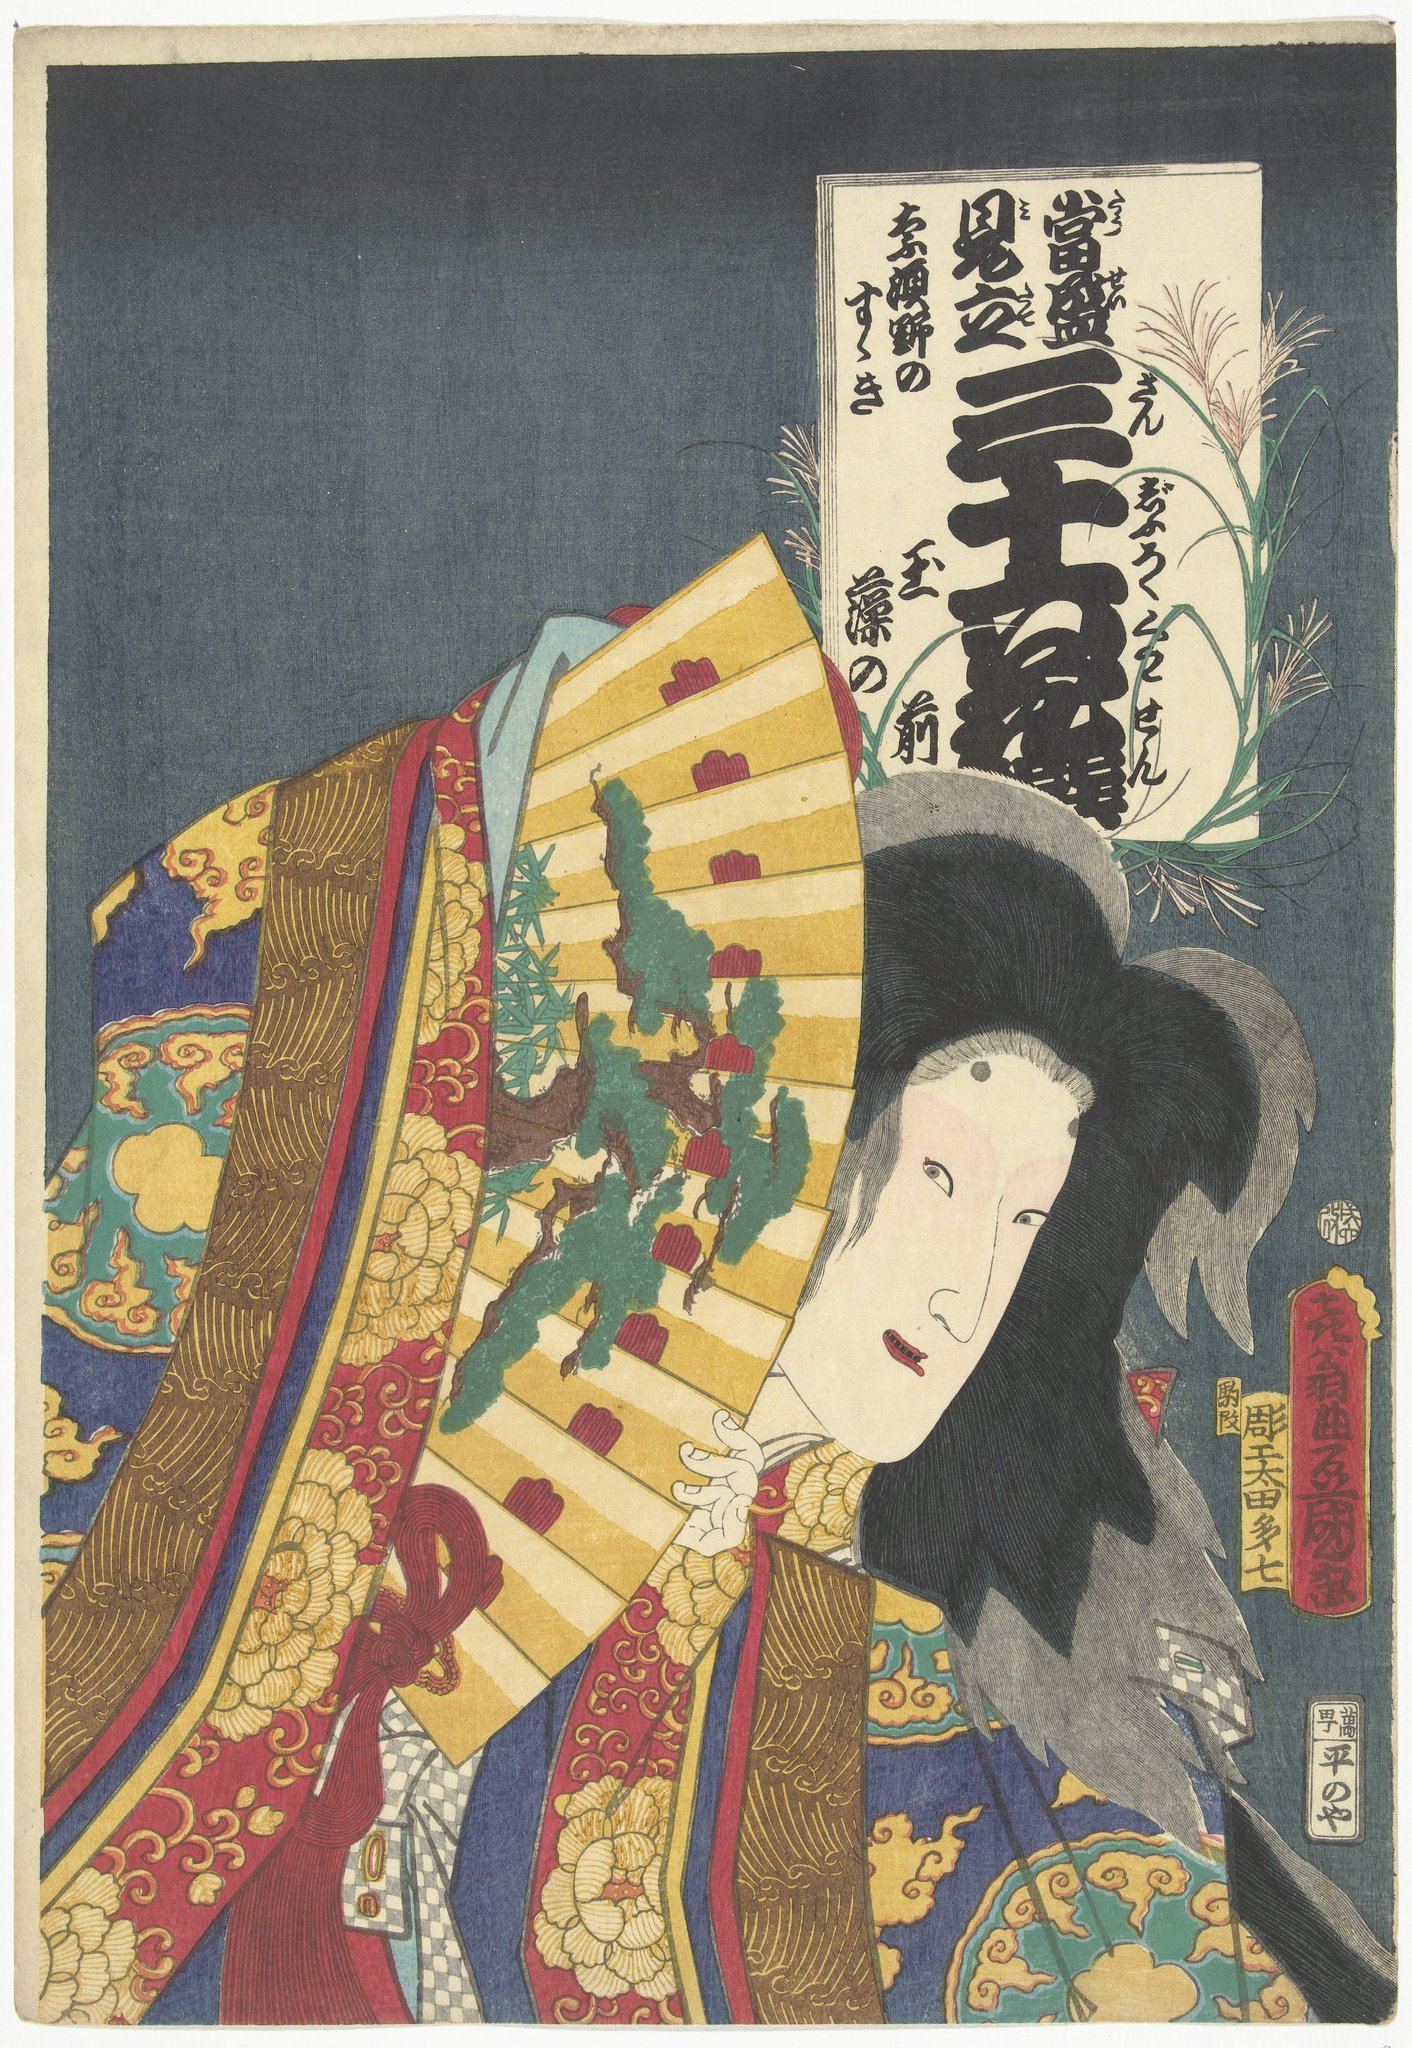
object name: print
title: Iwai Kumesaburo III als Tamamo no Mae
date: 1862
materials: paper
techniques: woodcut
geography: japan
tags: actor (on the stage)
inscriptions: date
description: De acteur Iwai Kumesaburo III in de rol van Tamamo no Mae, kijkend vanachter grote gele waaier met afbeelding van pijnboom en bamboe, welke in rechter hand wordt vastgehouden; rechtsboven rechthoekig cartouche met bloeiend gras.